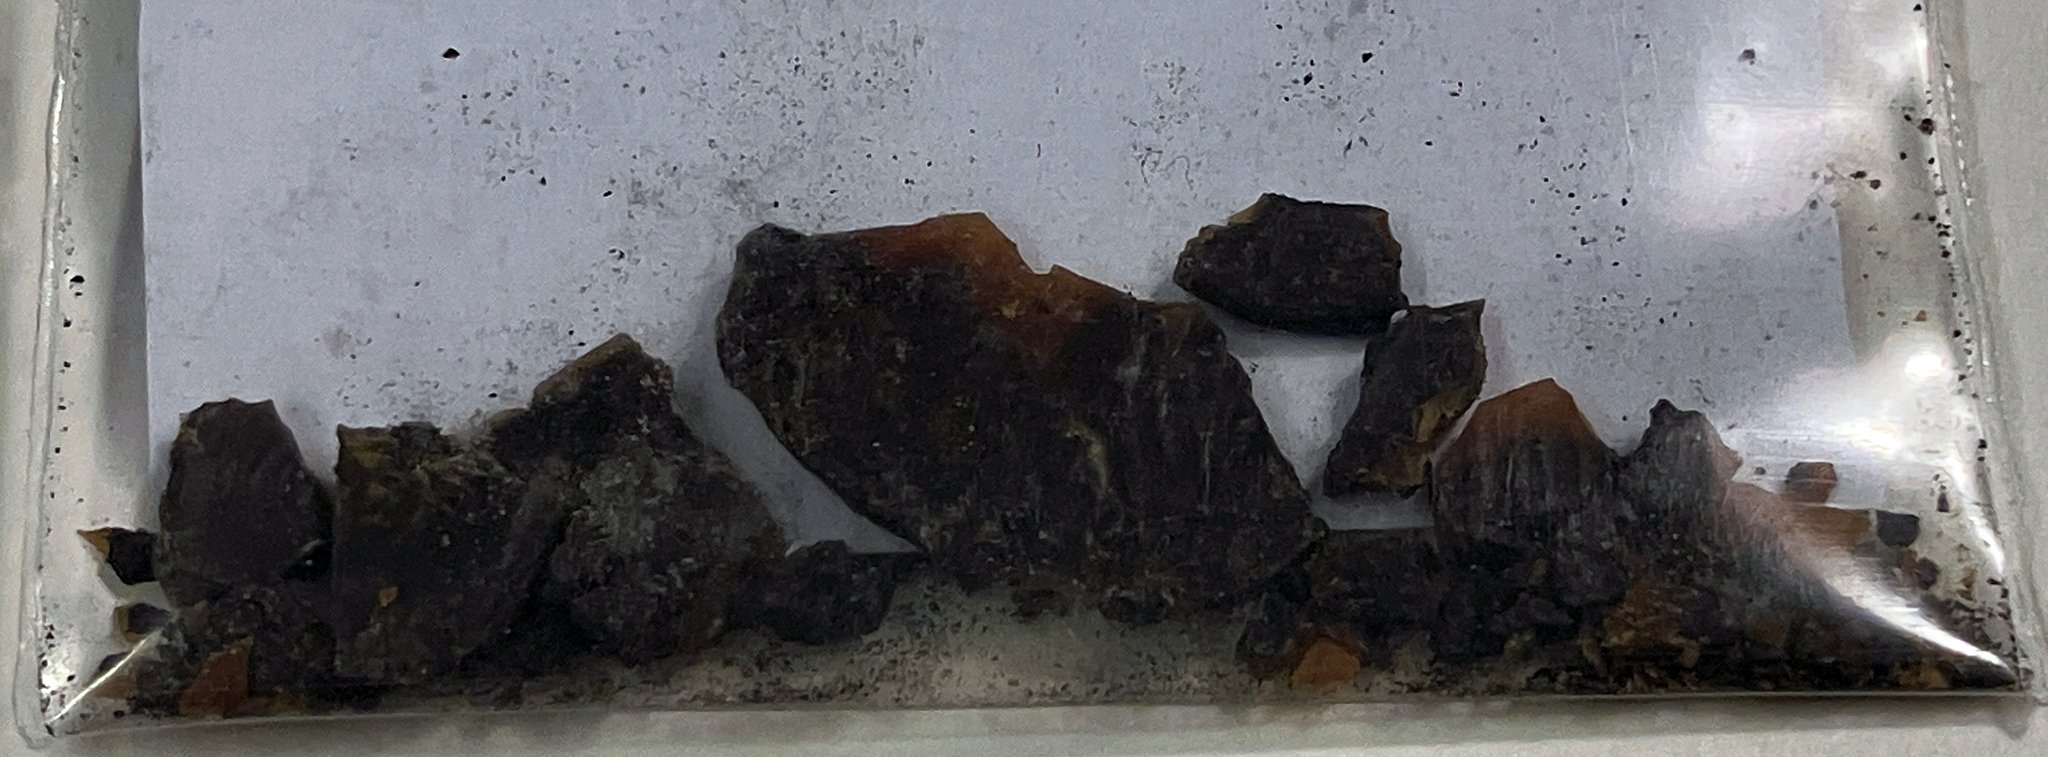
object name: coin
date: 701-833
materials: copper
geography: iran